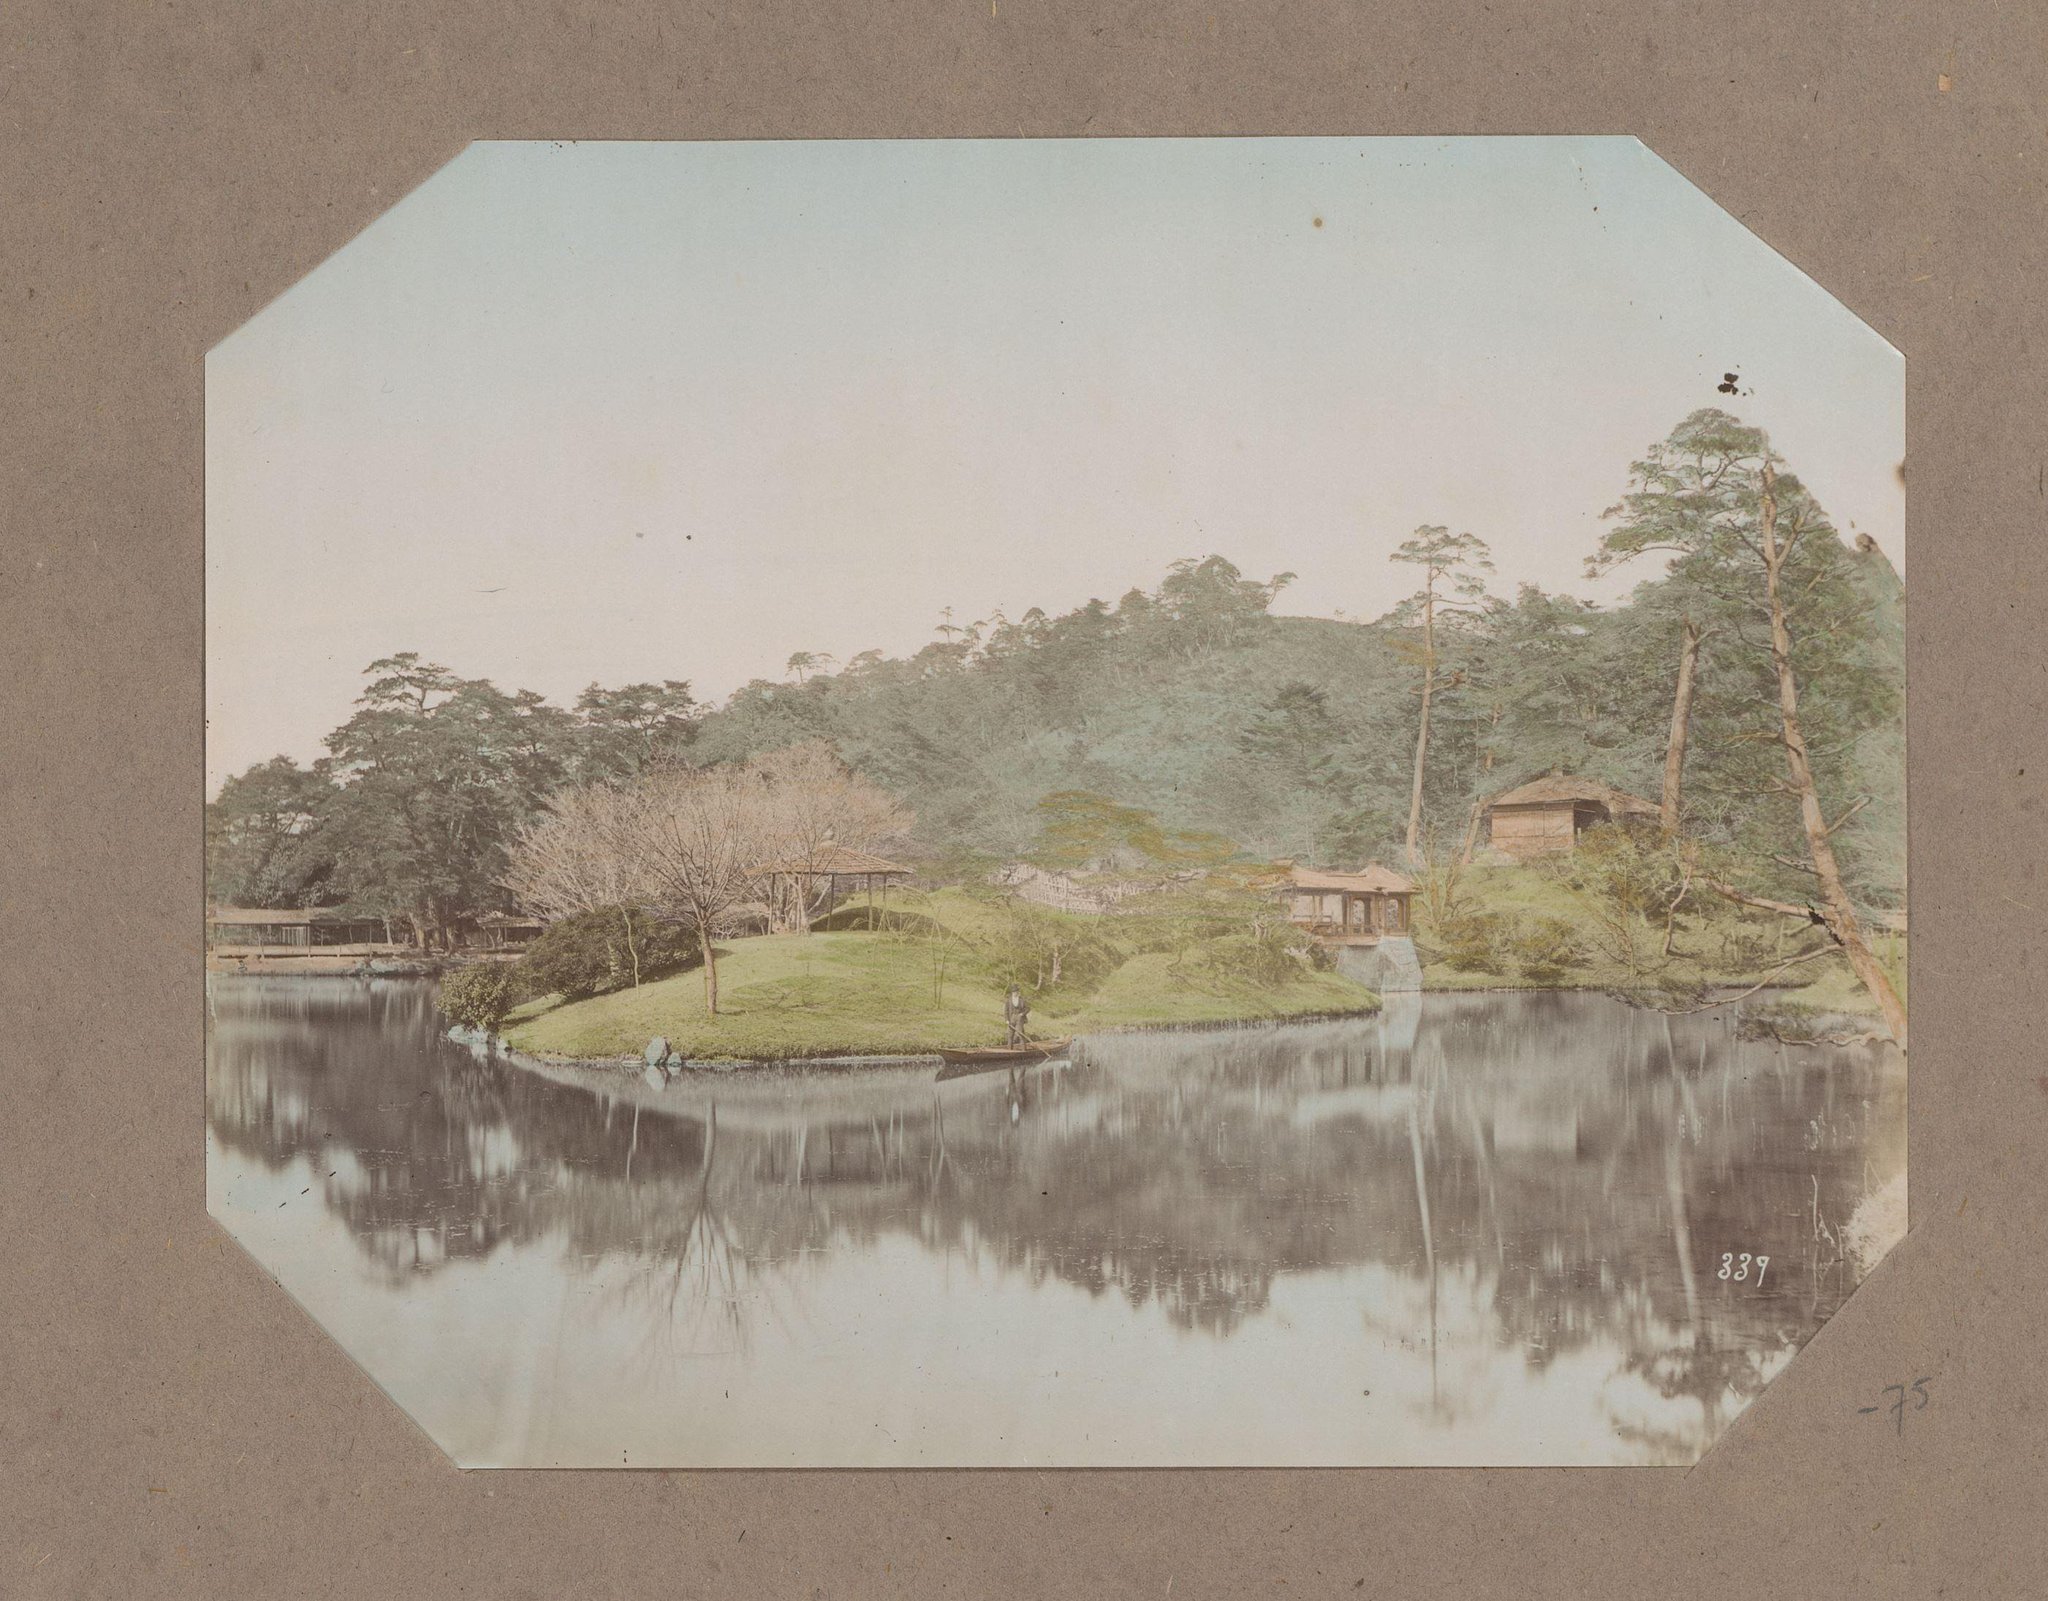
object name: photograph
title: Gezicht op een tuin aan het water in Japan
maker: Anonymous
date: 1890-1903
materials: paper, photographic support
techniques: albumen print, hand coloring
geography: japan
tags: garden, water course, japan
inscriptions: number: ‘339’